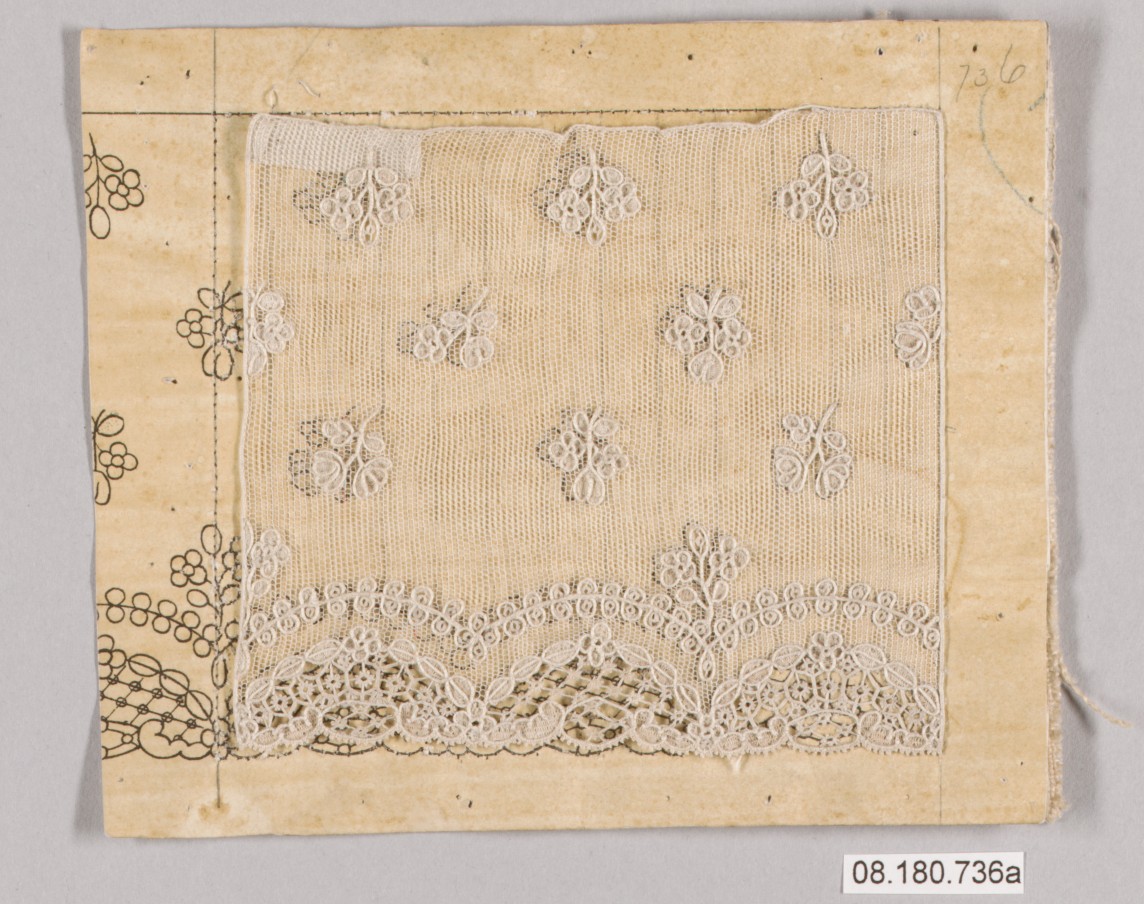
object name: sample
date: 1701-1800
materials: lace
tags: flowers